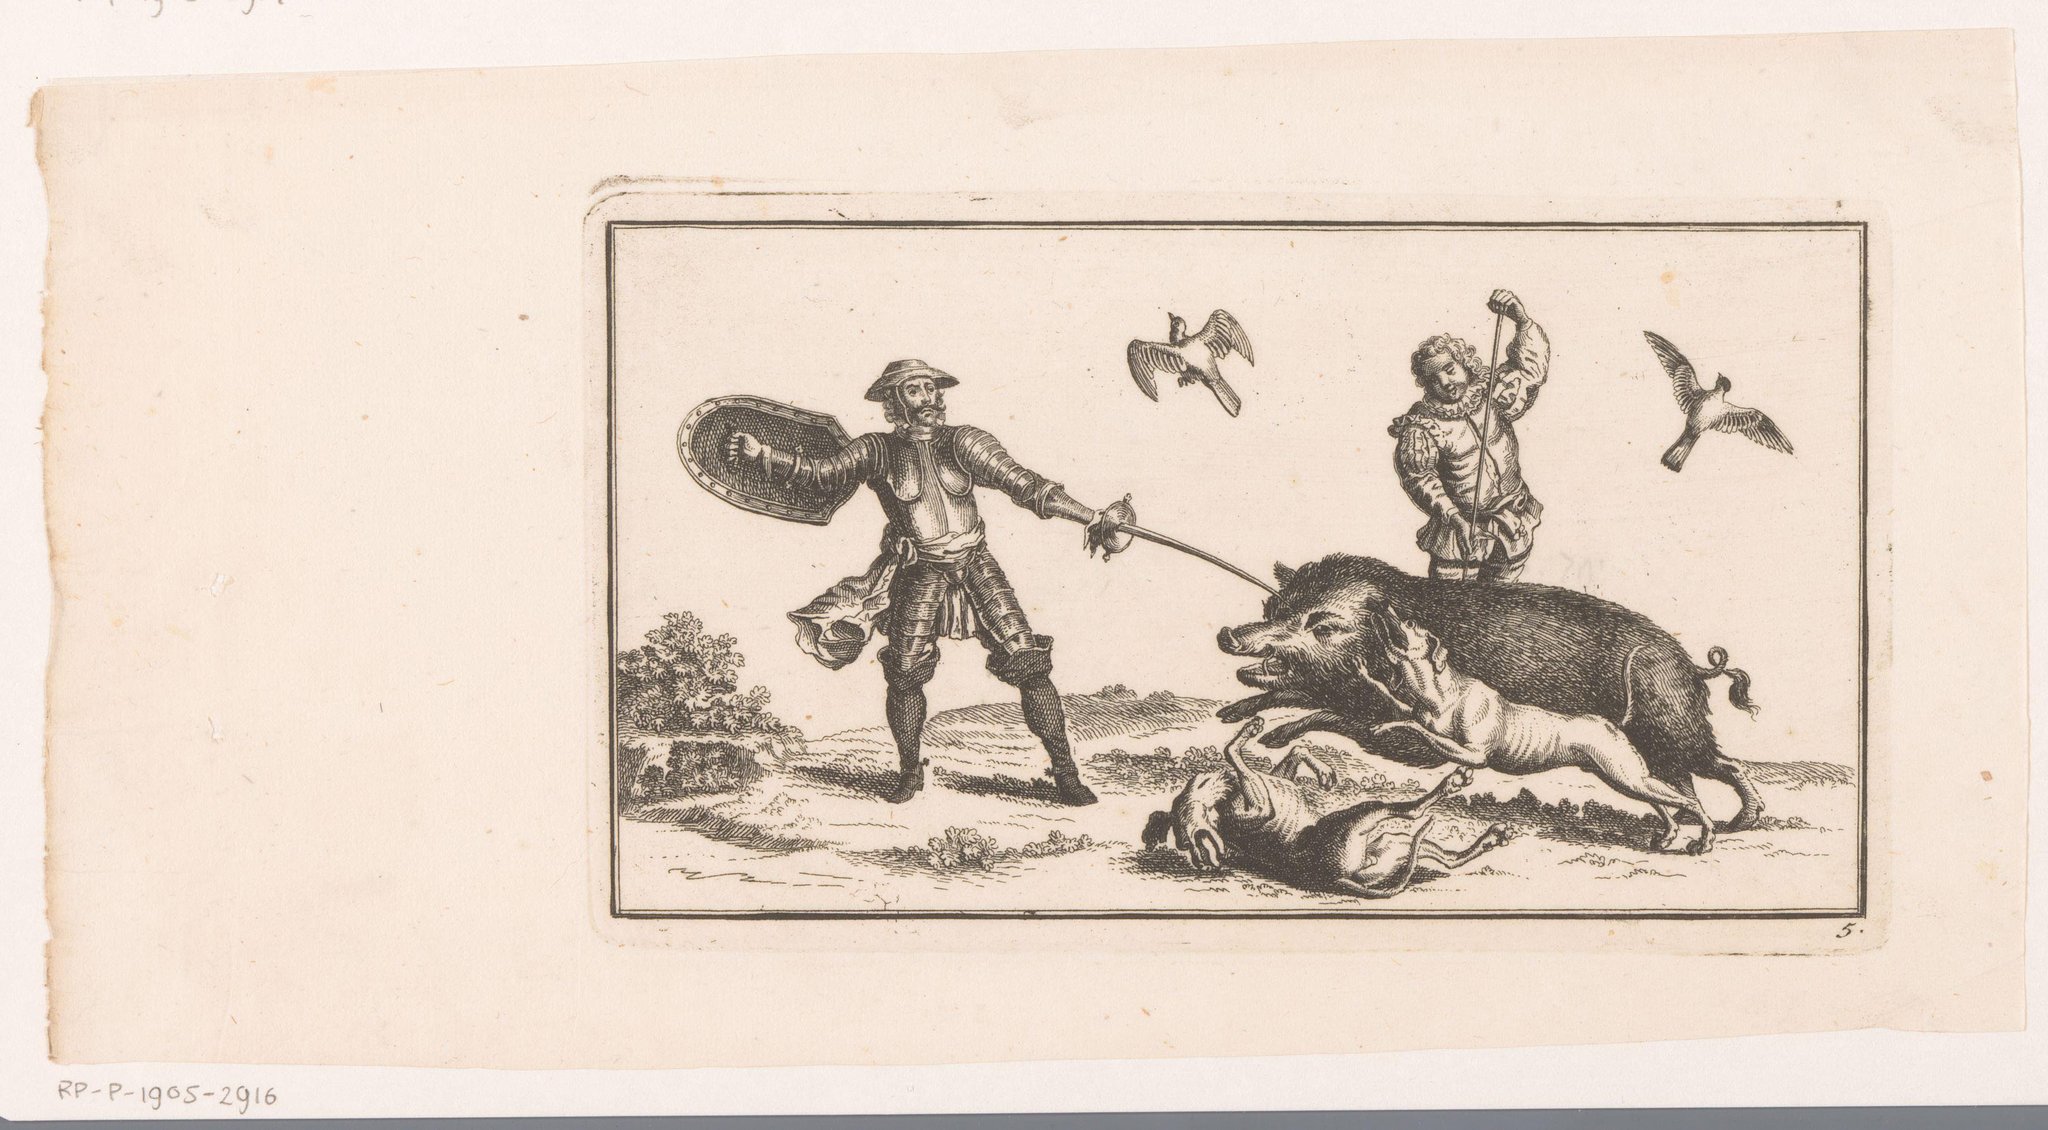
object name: print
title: Scène uit het verhaal van Don Quichot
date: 1725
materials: paper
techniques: etching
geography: nuremberg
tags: birds, don quixote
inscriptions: collector's mark: Lugt 2228